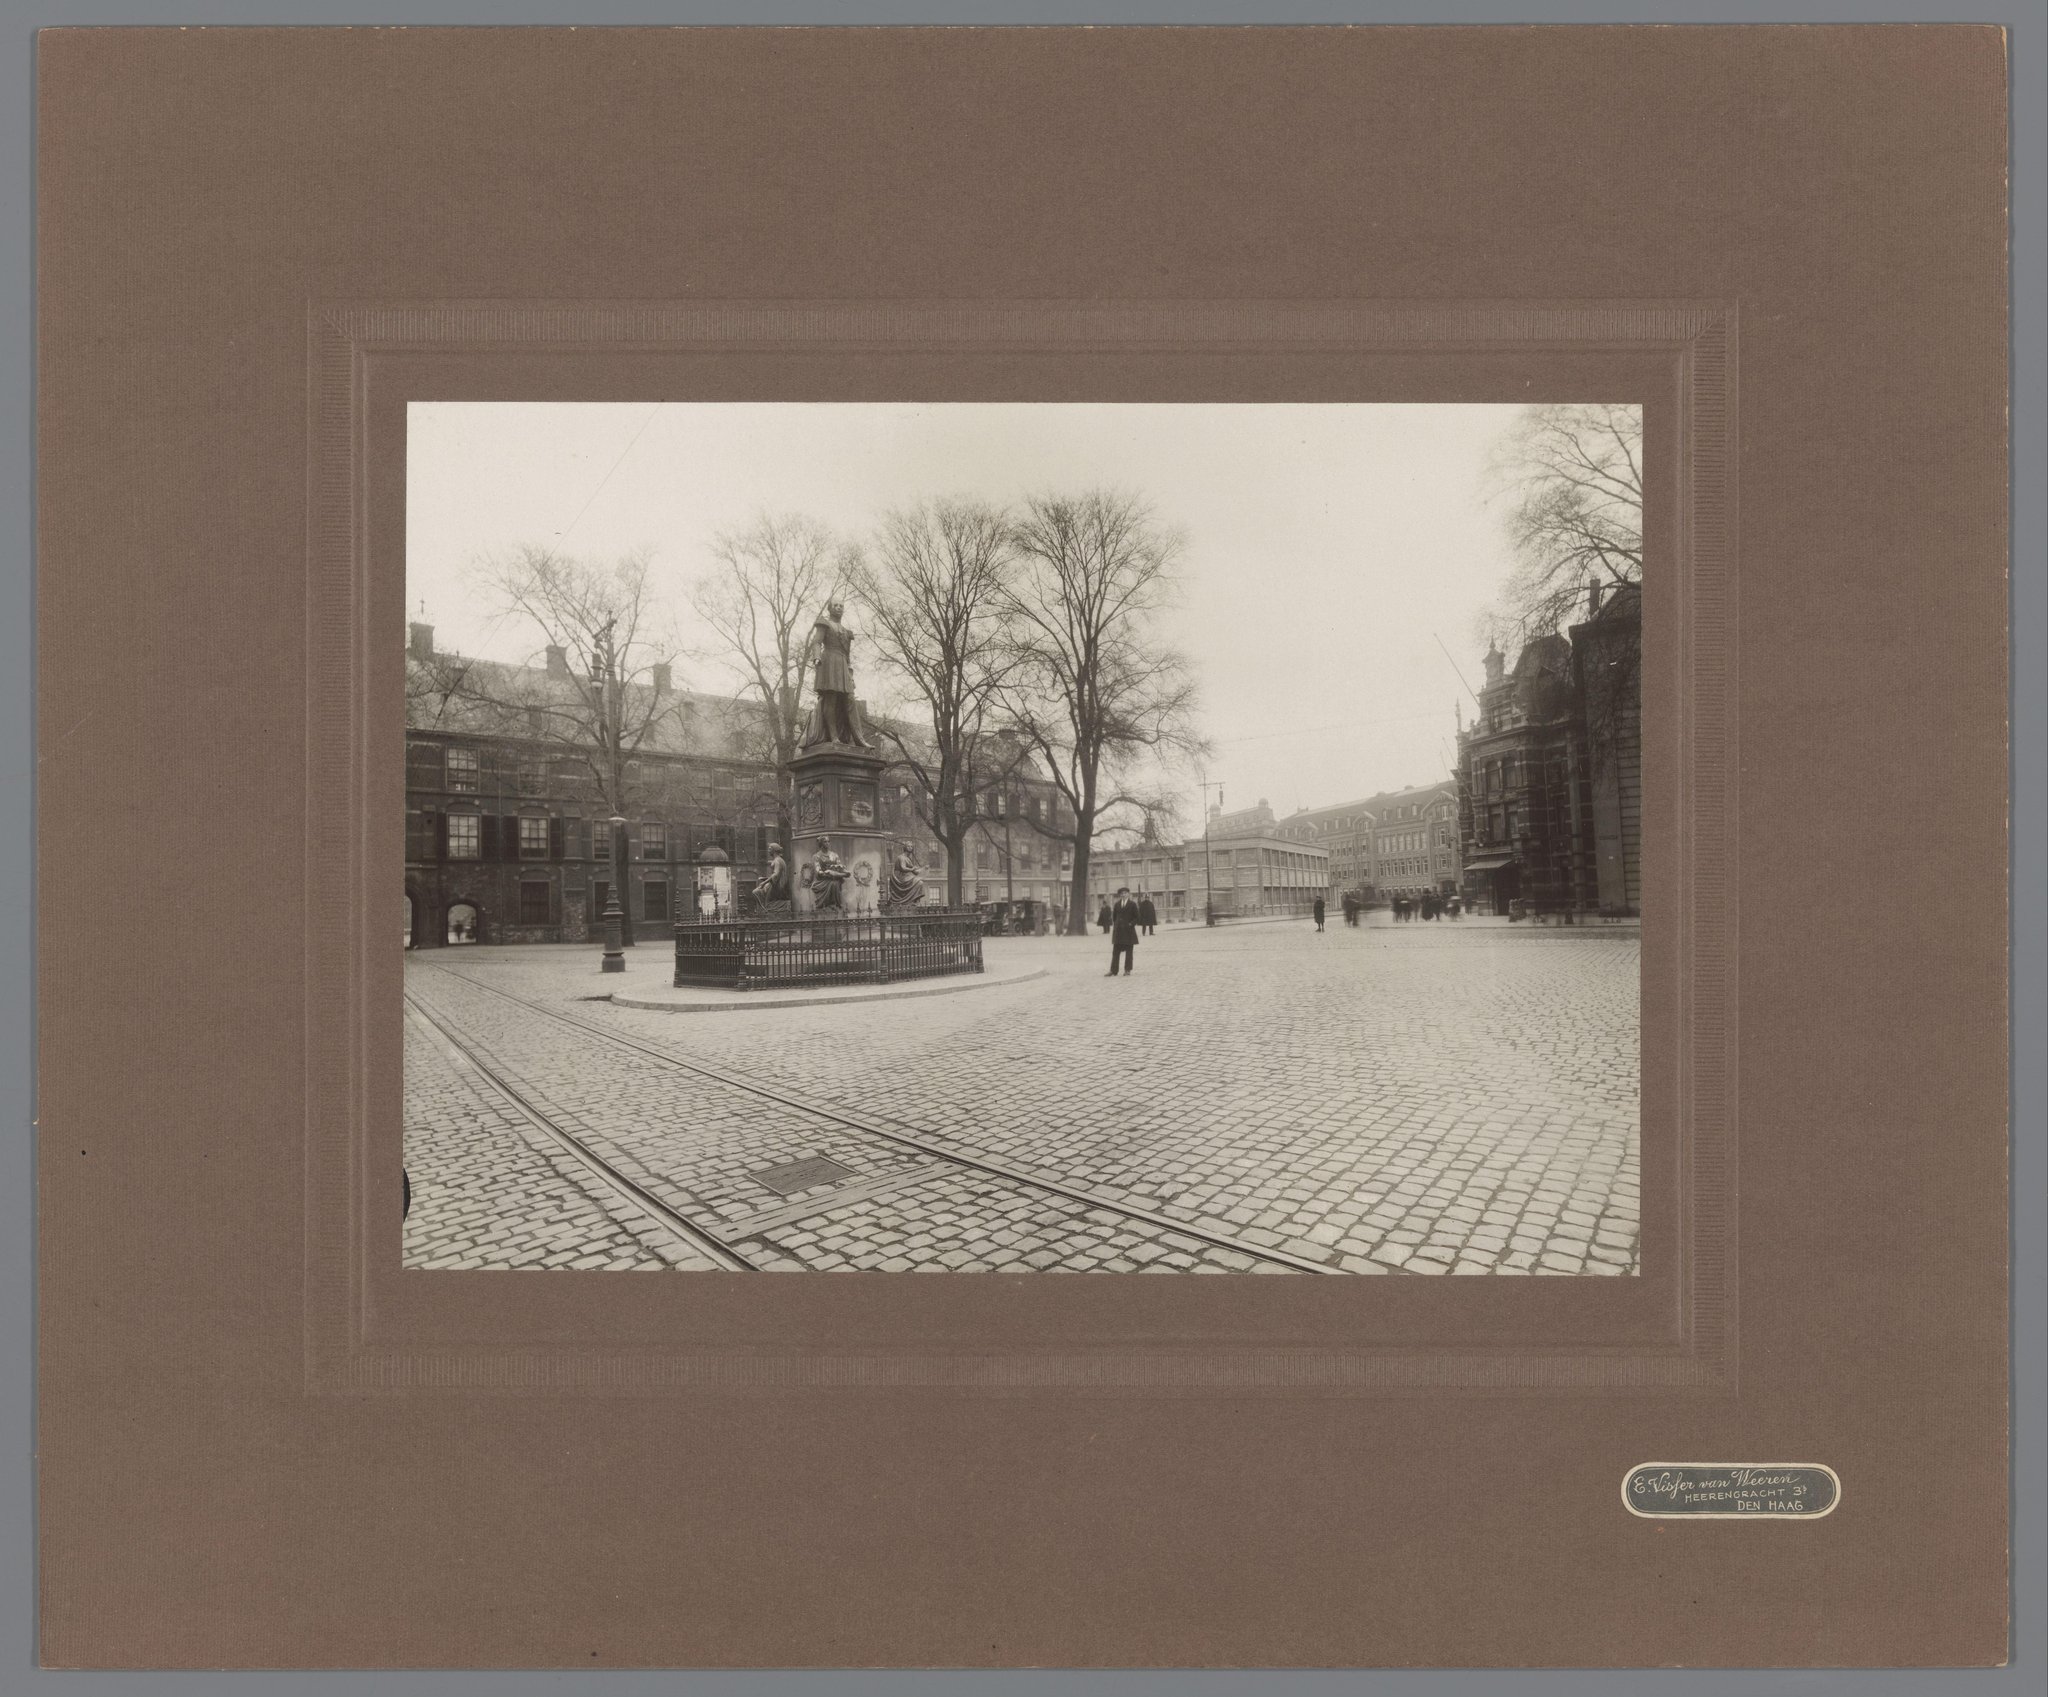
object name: photograph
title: Gezicht op het buitenhof met het standbeeld van koning Willem II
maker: e. visser von weeren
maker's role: fotograaf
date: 1900-1921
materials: cardboard, photographic support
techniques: gelatin silver print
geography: the hague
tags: the hague, william ii of the netherlands, monument, statue (+ city(-scape) with figures, staffage)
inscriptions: number: ‘141/ no.26’, date: ‘18 apr 1921’, annotation: ‘II kamer, Haag/ binnenhof/ buitenhof/ monument’, inscription: ‘E. Visser van Weeren/ Heerengracht 3b/ Den Haag’